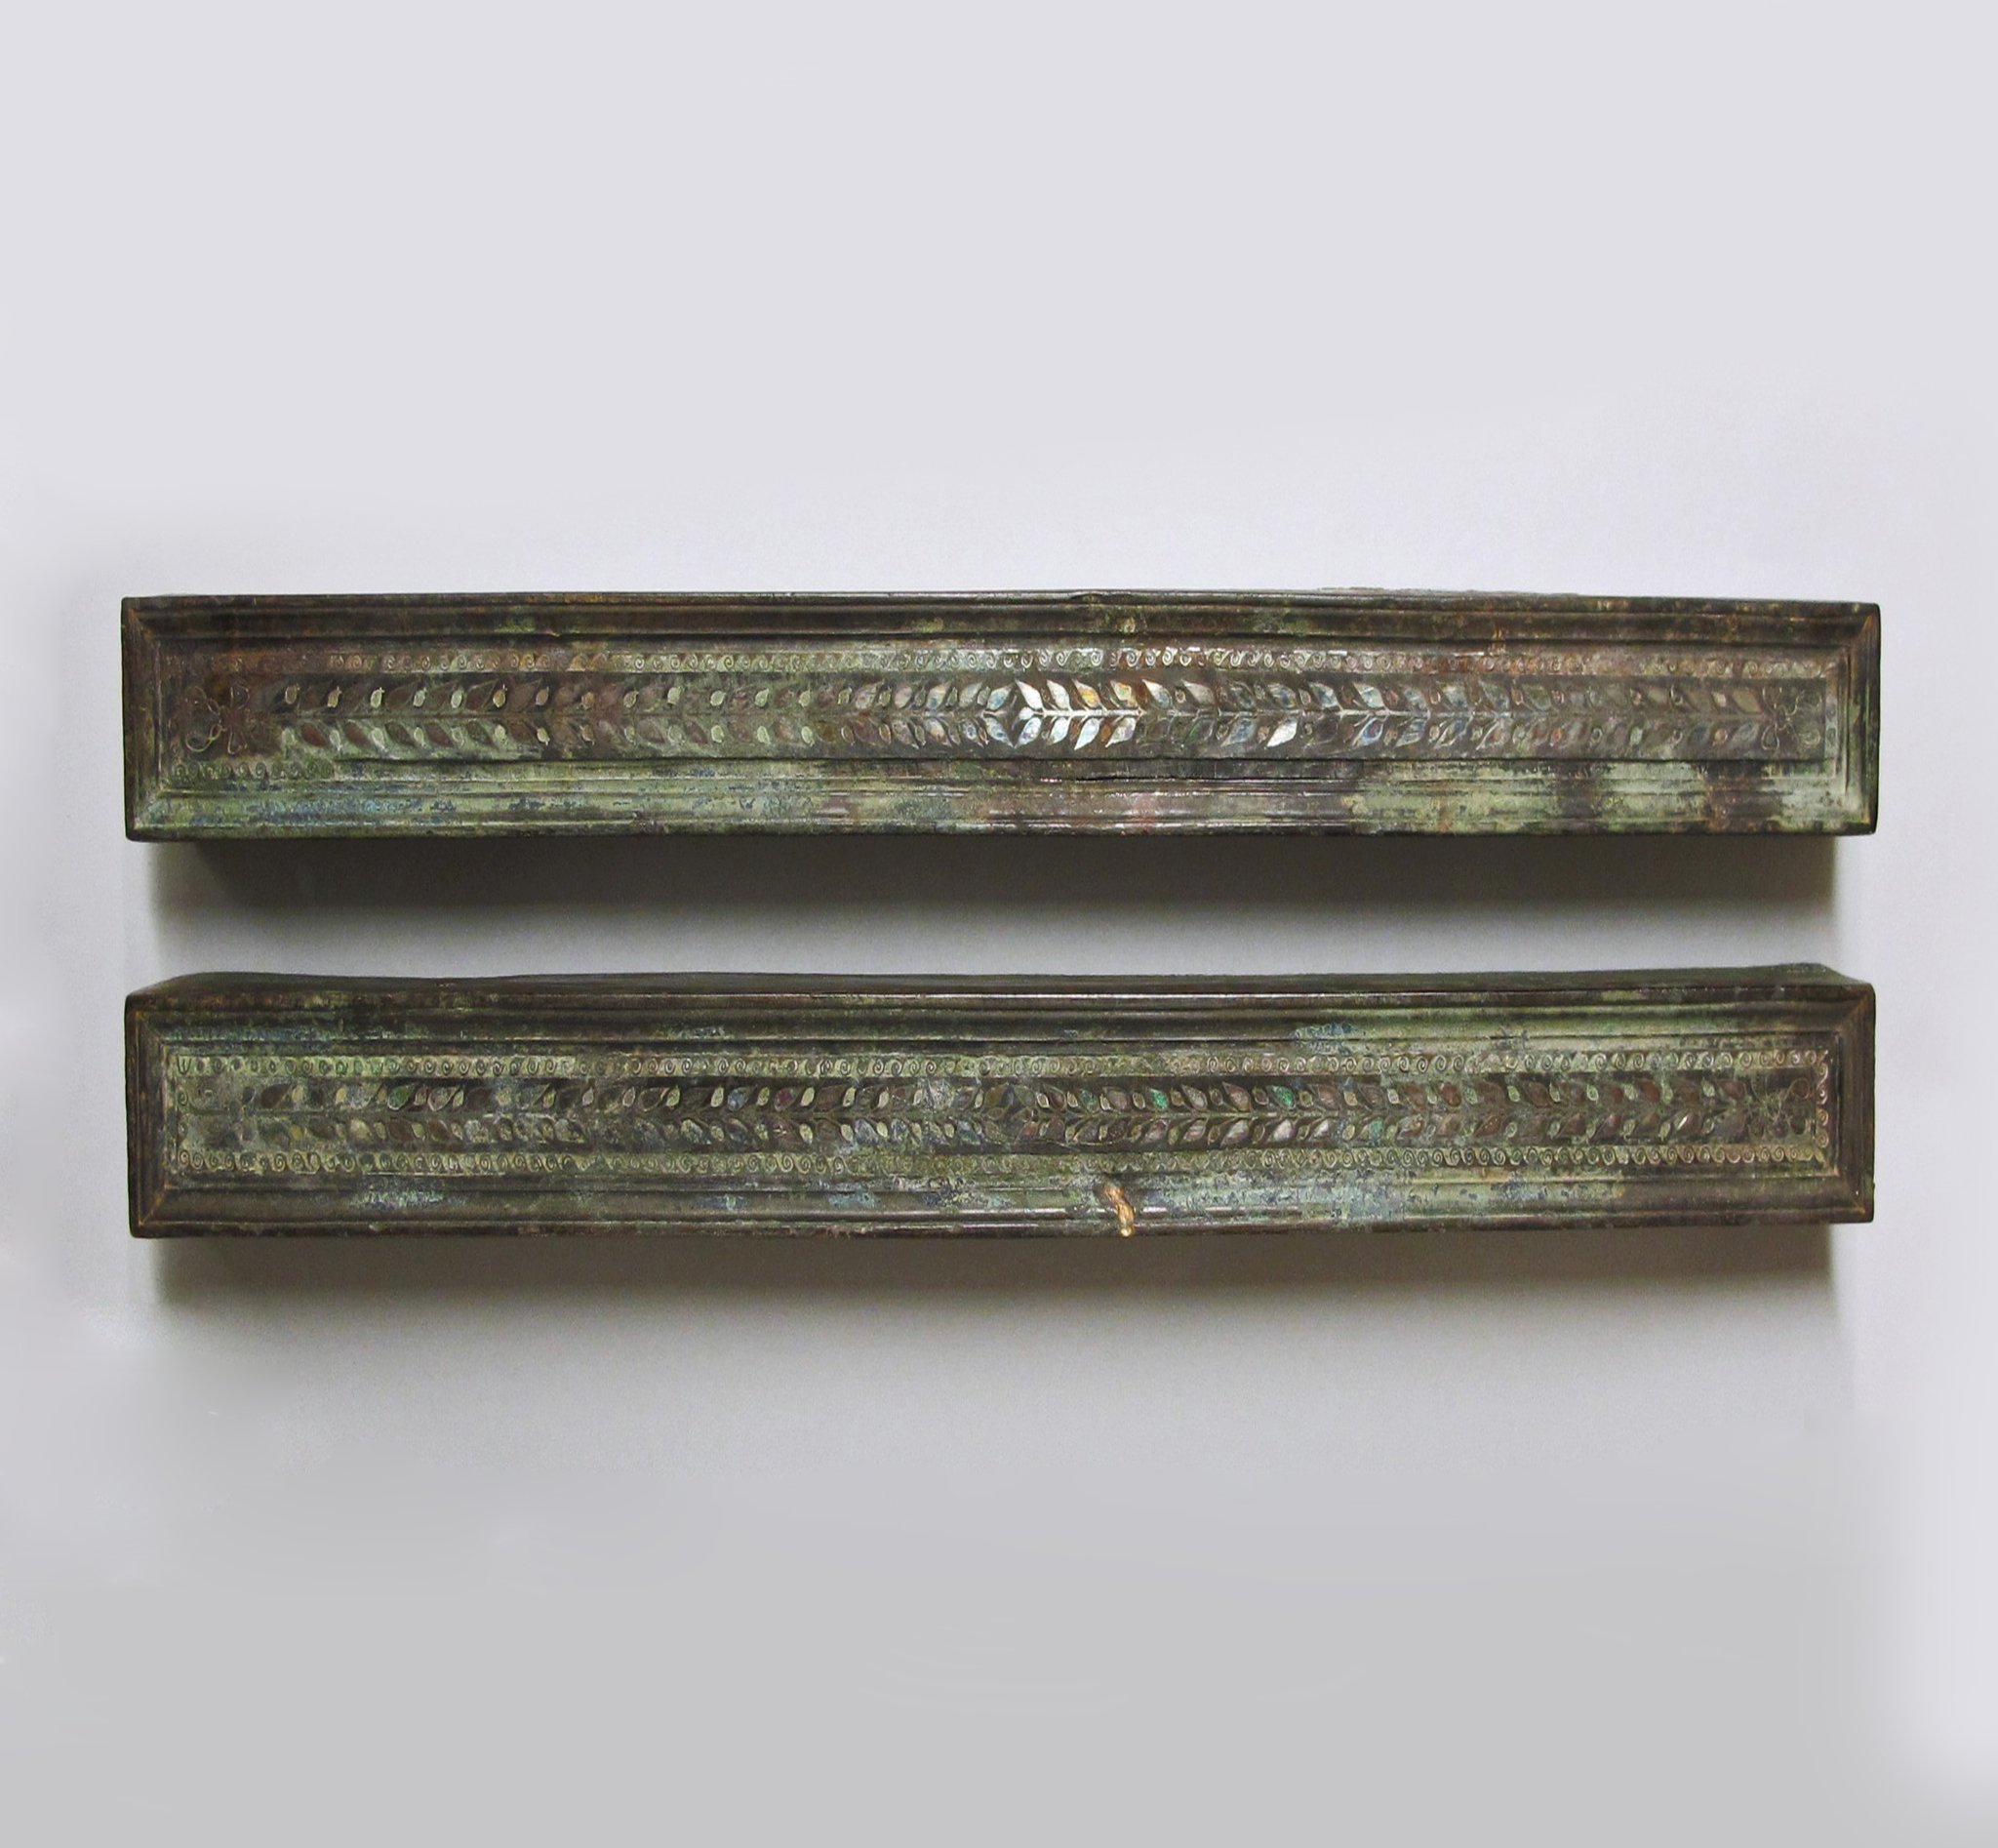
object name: furniture attachment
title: Bronze furniture attachments with silver inlay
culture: greek or roman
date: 100 BCE-33 CE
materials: bronze, silver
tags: leaves